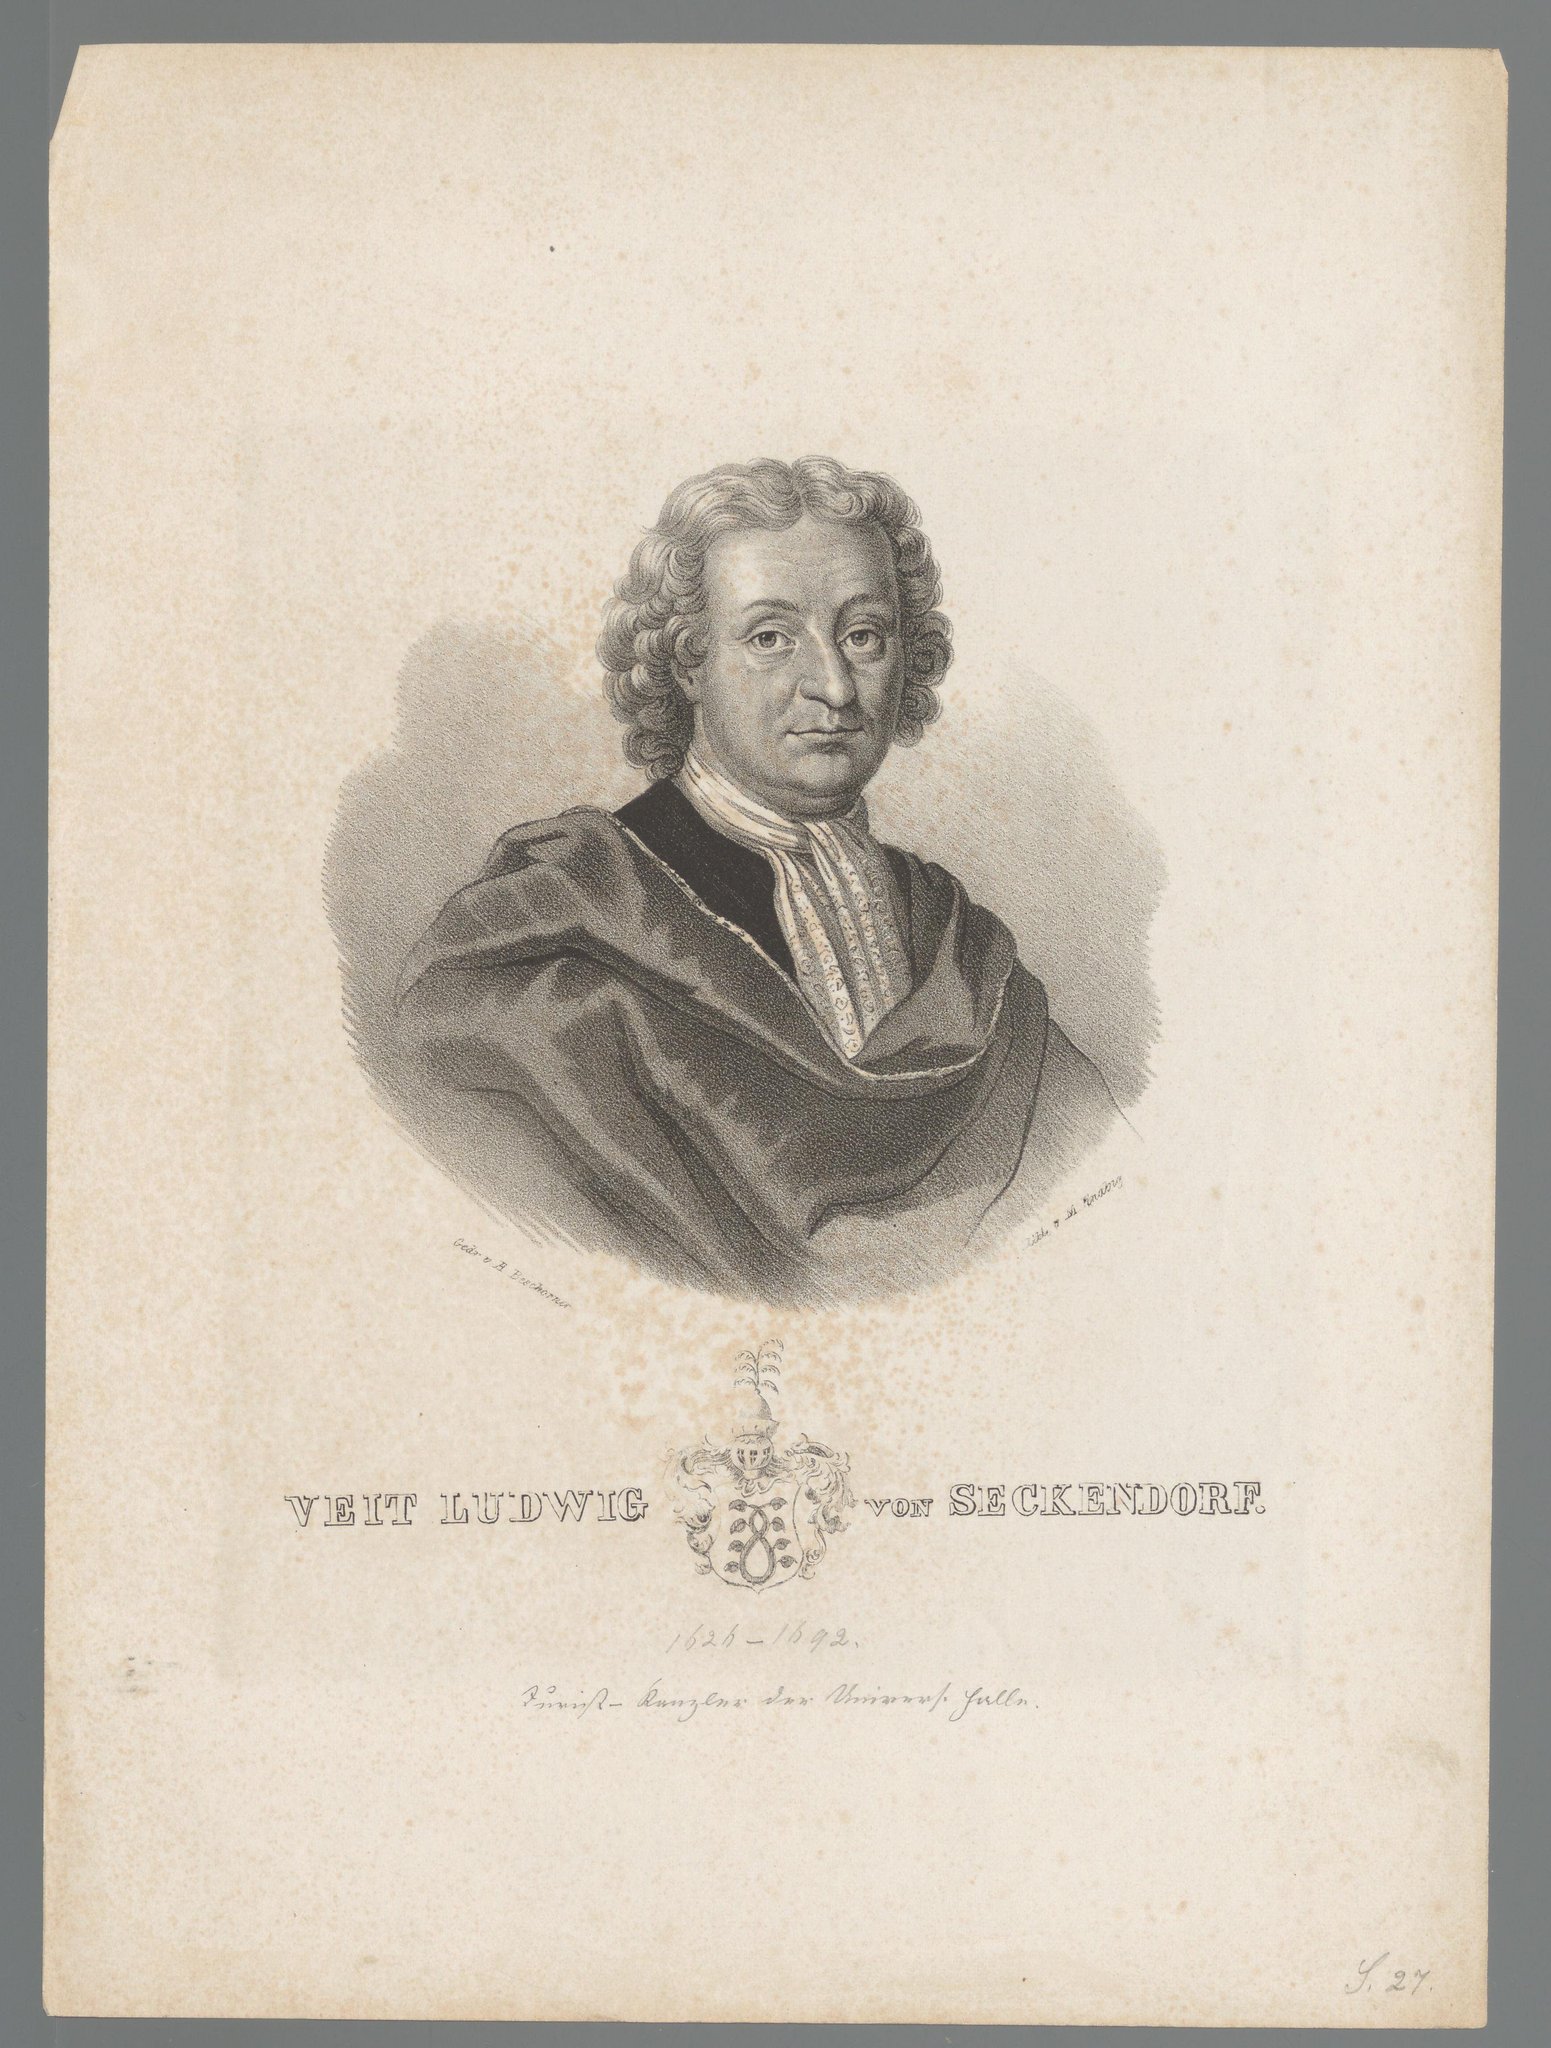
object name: print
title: Veit Ludwig von Seckendorf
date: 1814-1876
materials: paper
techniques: lithograph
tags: veit ludwig von seckendorf, adult man, historical persons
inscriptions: collector's mark: Lugt 2228